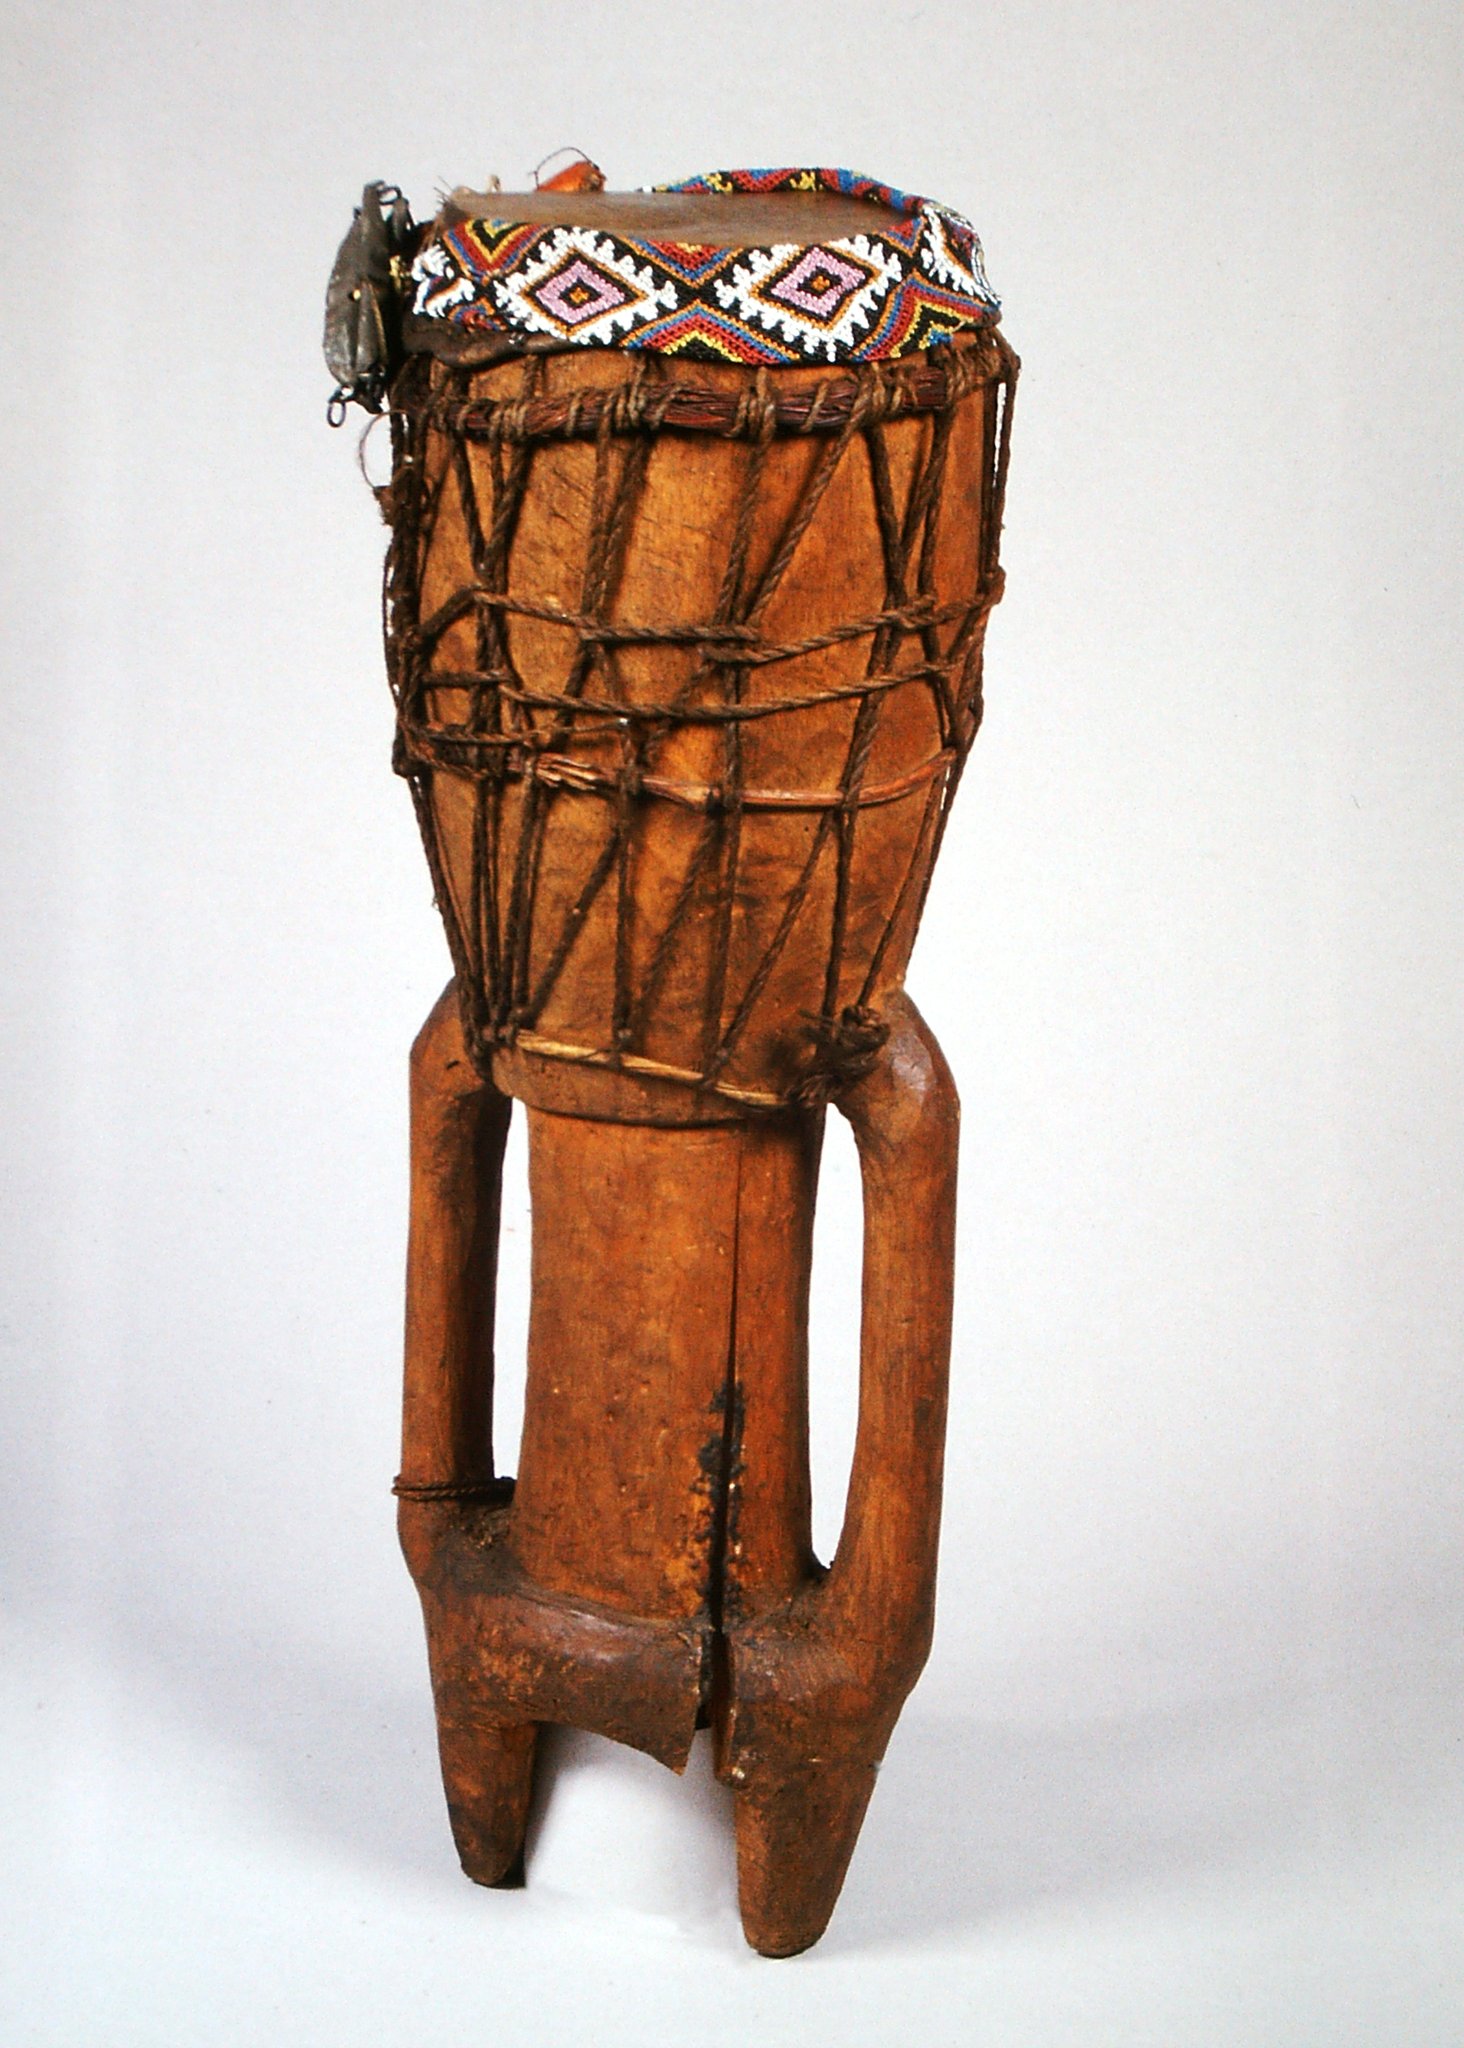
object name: drum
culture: sierra leonean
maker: susu people ?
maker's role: maker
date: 1801-1900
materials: wood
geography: sierra leone